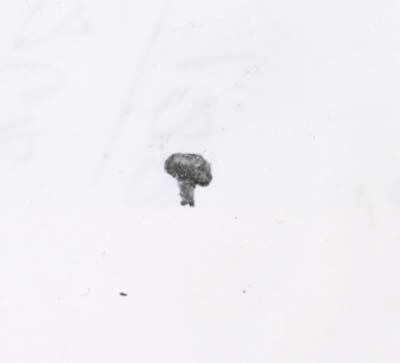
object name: tack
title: Tacks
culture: iranian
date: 900-801 BCE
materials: bronze, copper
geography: iran